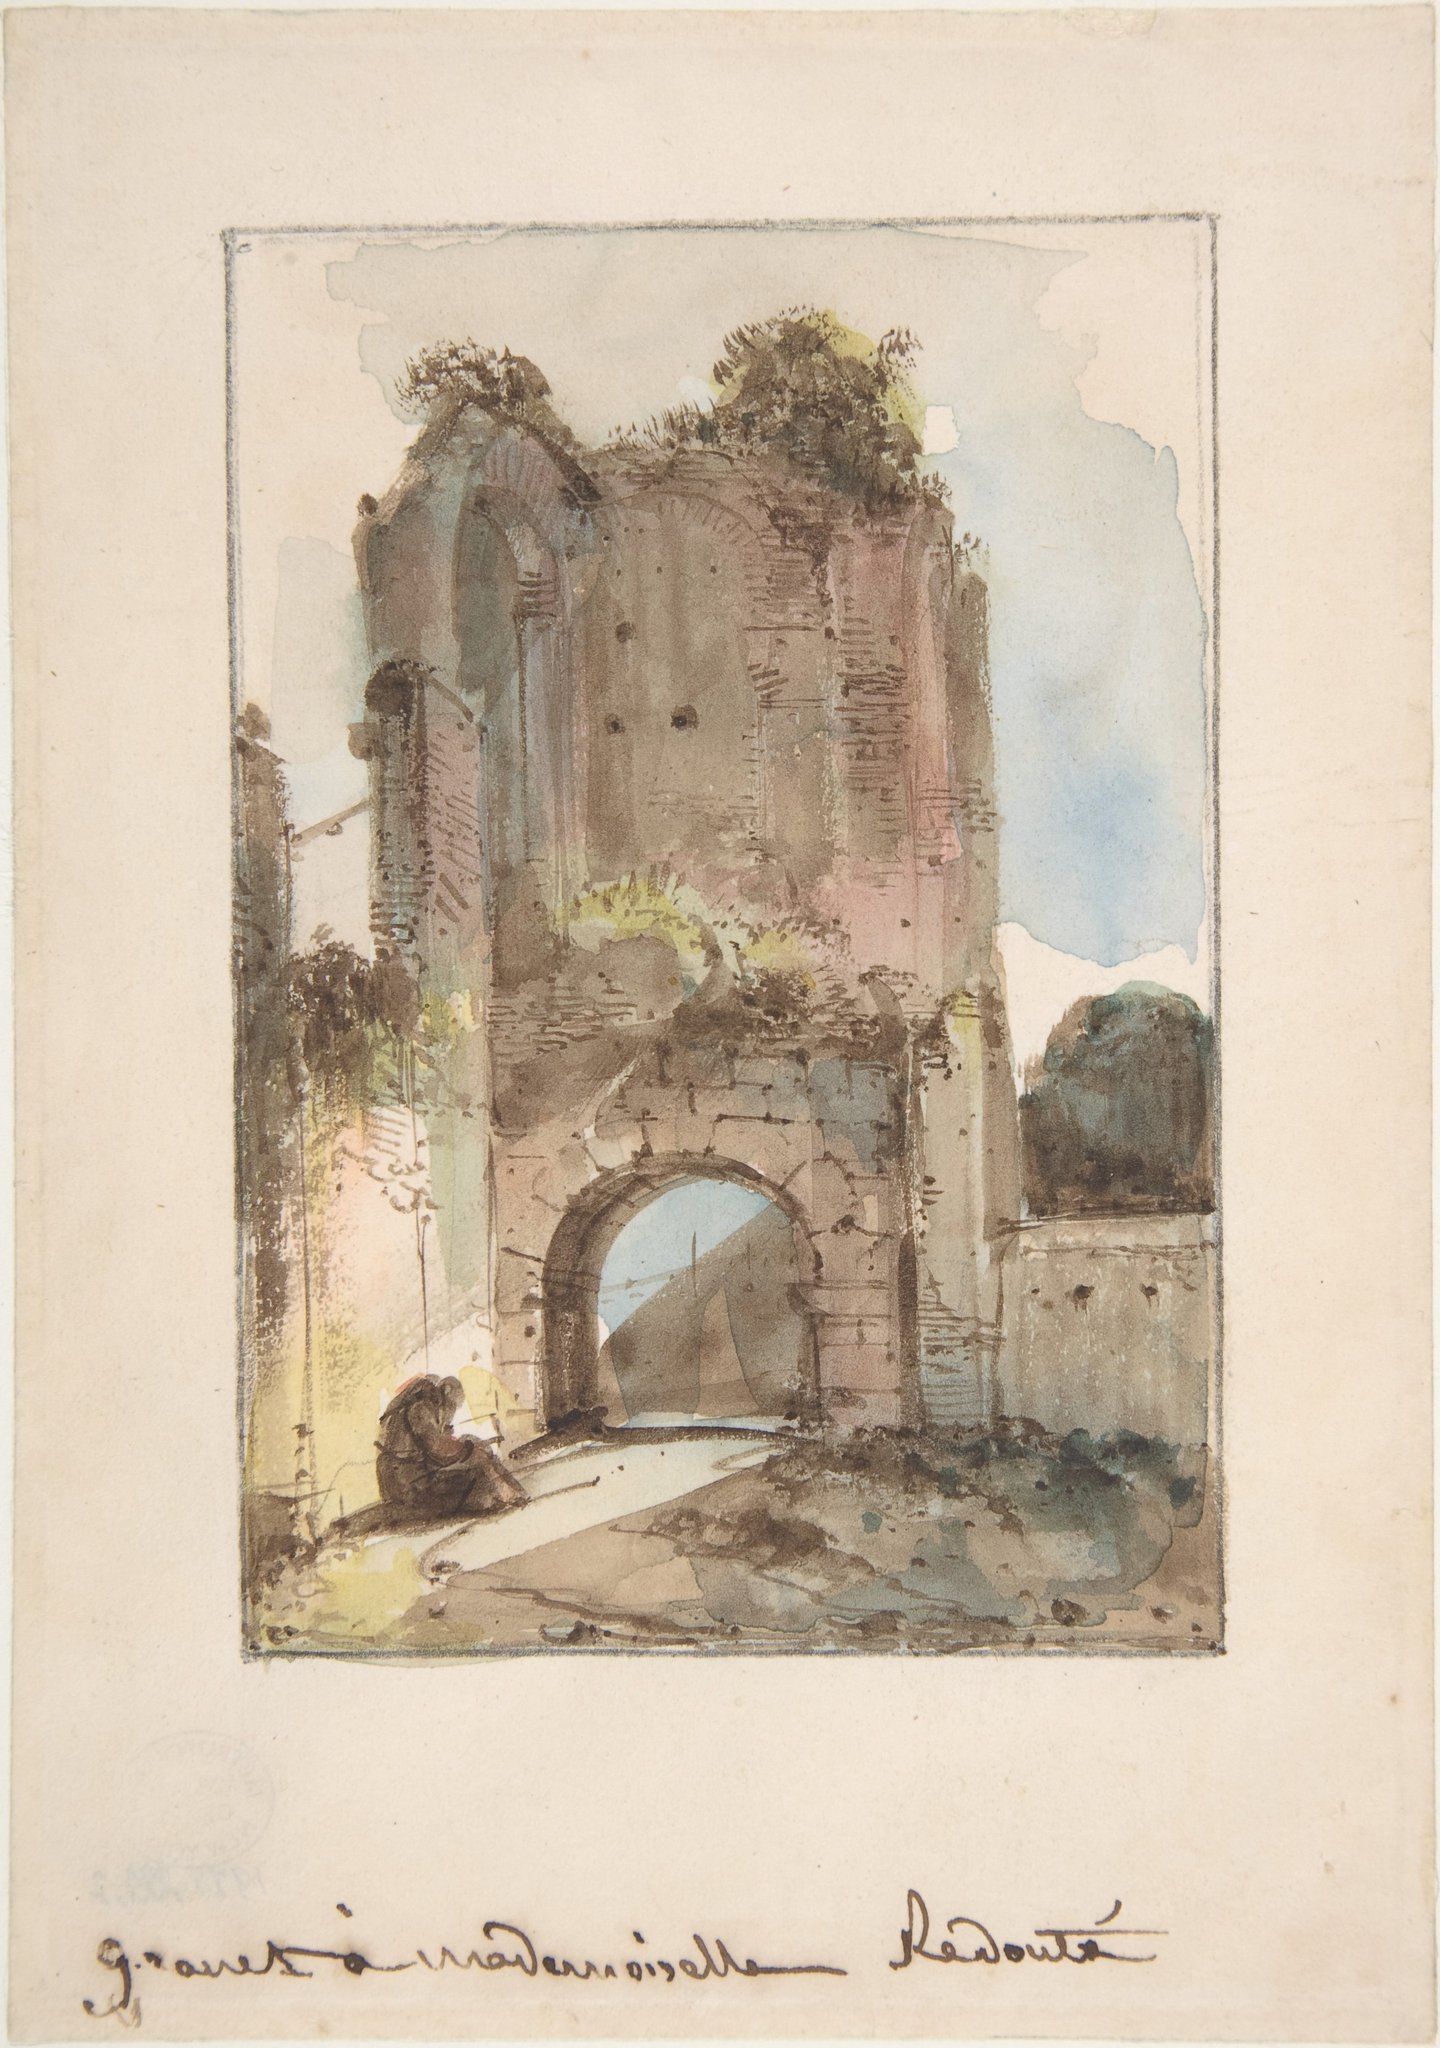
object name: drawing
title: Monk Seated Before a Ruined Gateway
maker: françois marius granet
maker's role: artist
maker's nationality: french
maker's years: 1775-1849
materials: ink, watercolor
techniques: pen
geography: france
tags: ruins,monks